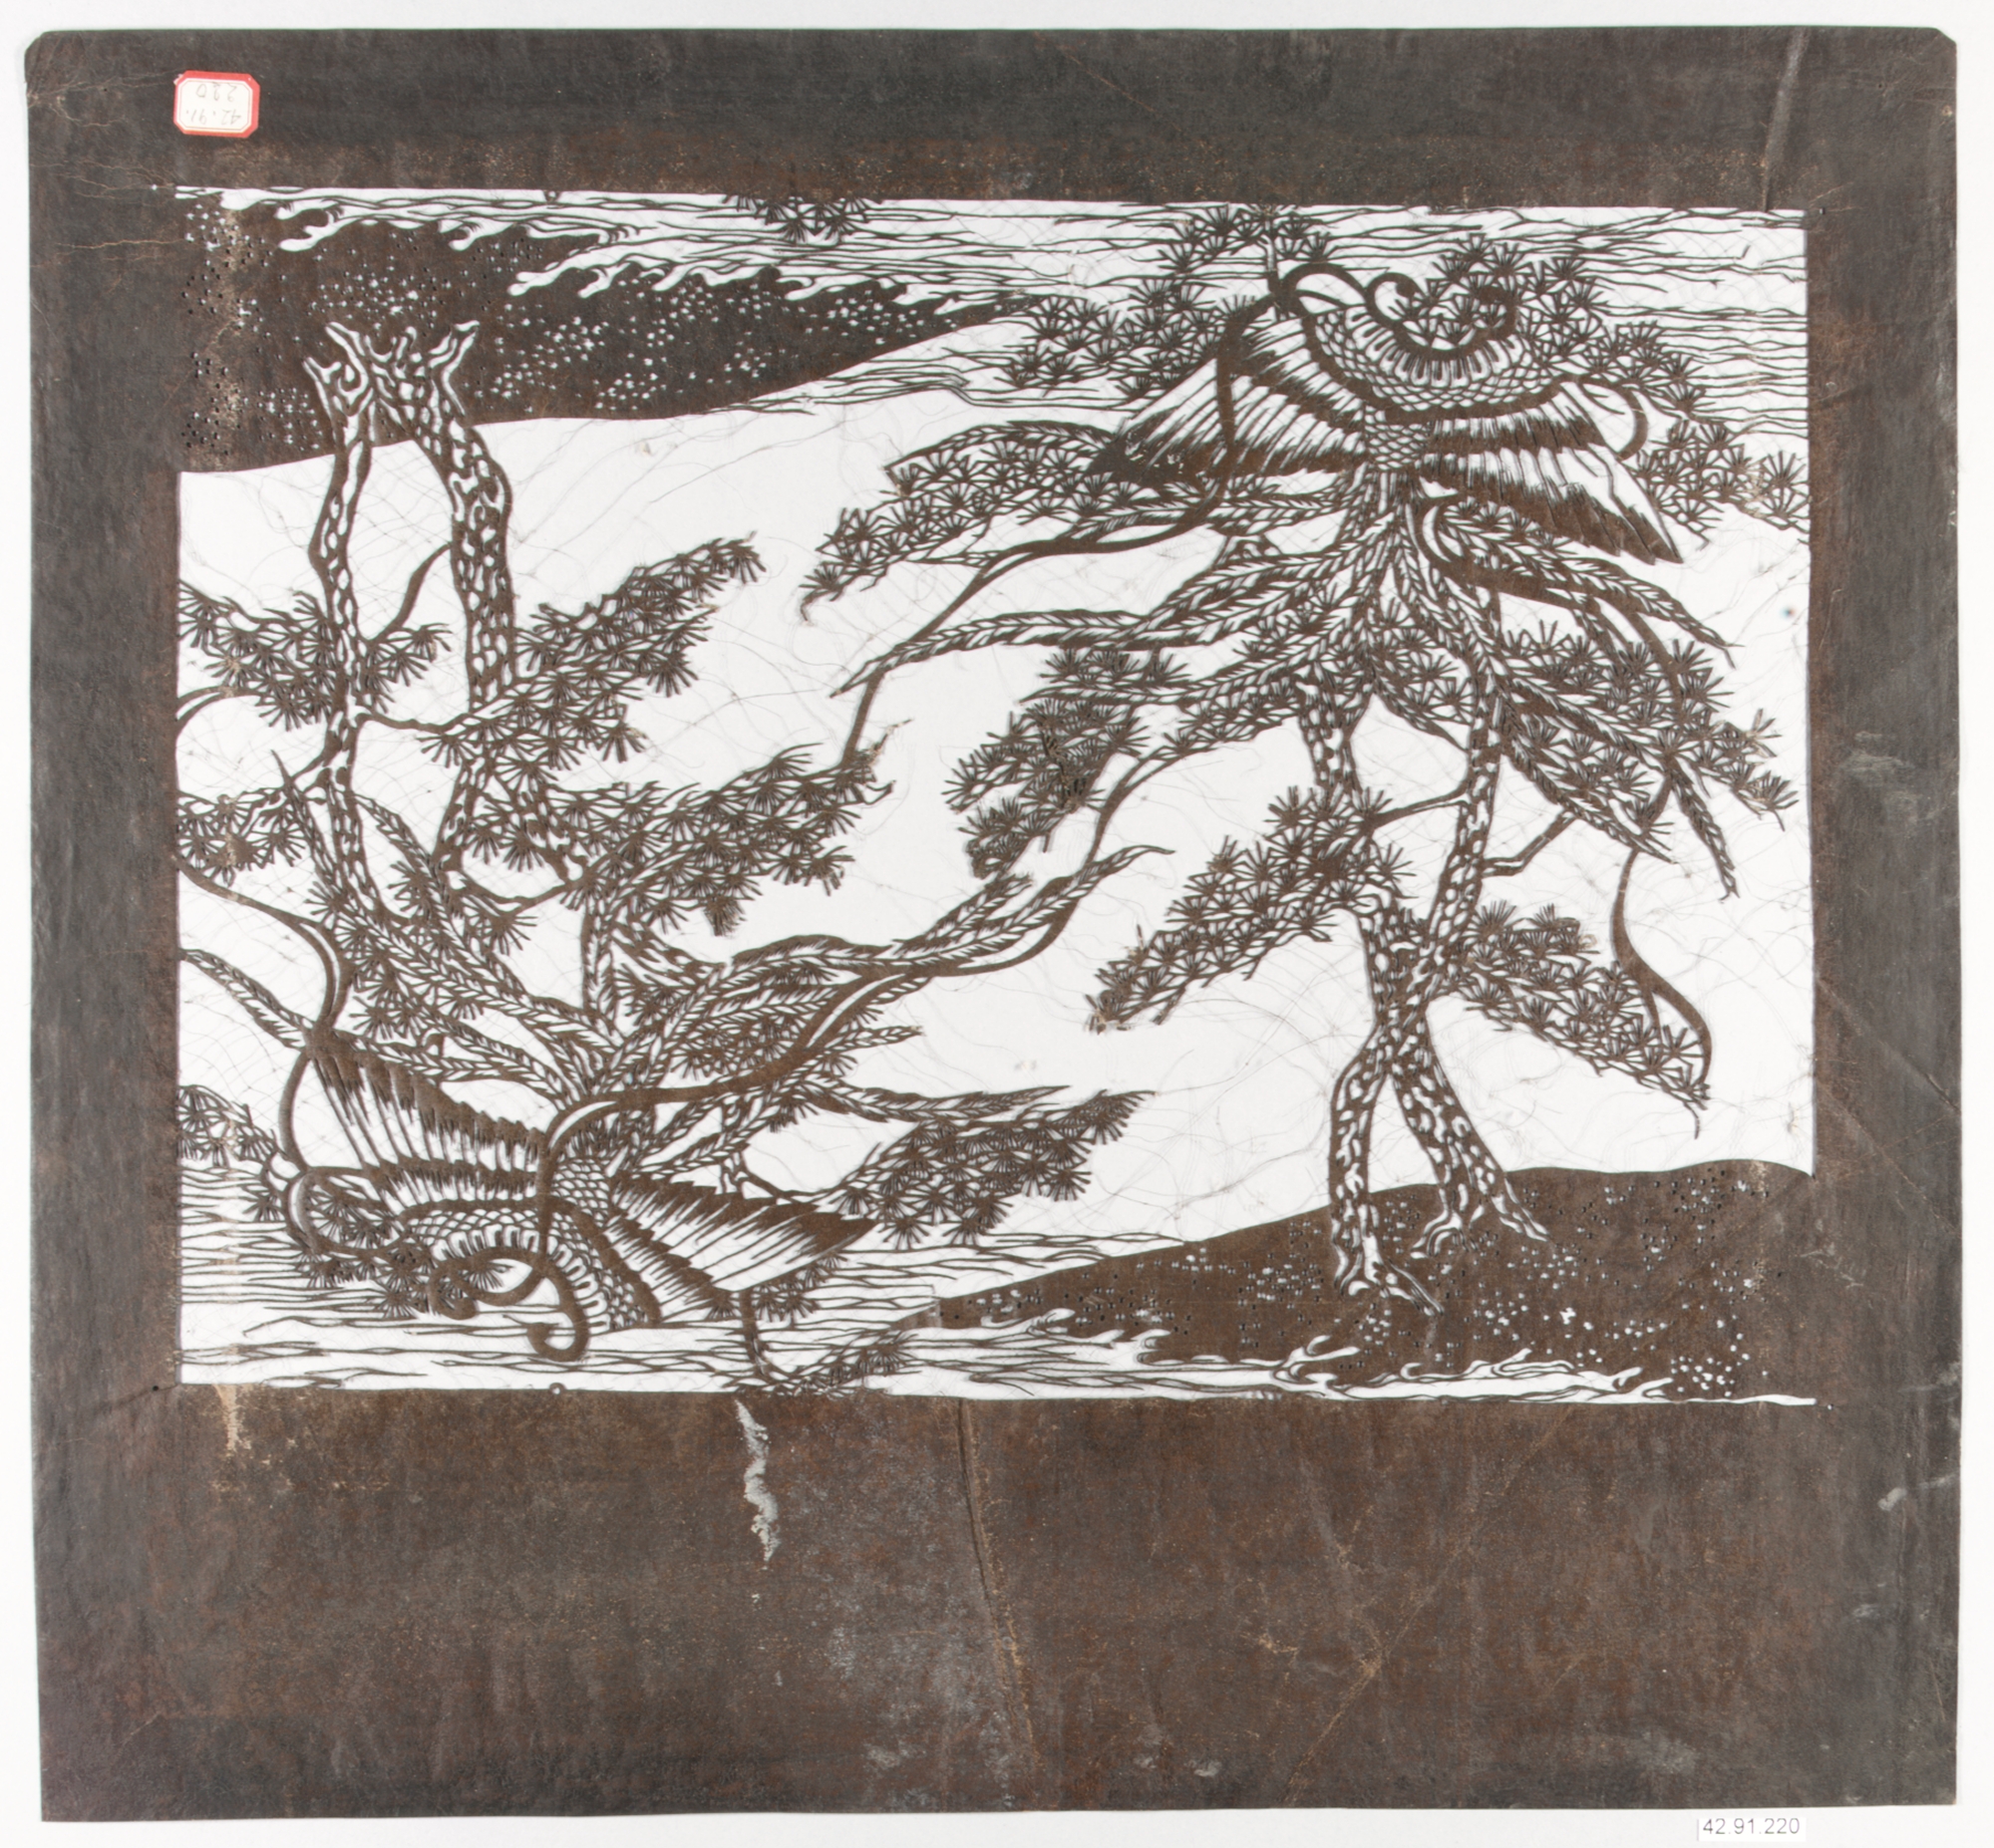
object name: stencil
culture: japanese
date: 1801-1900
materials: paper, silk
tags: trees